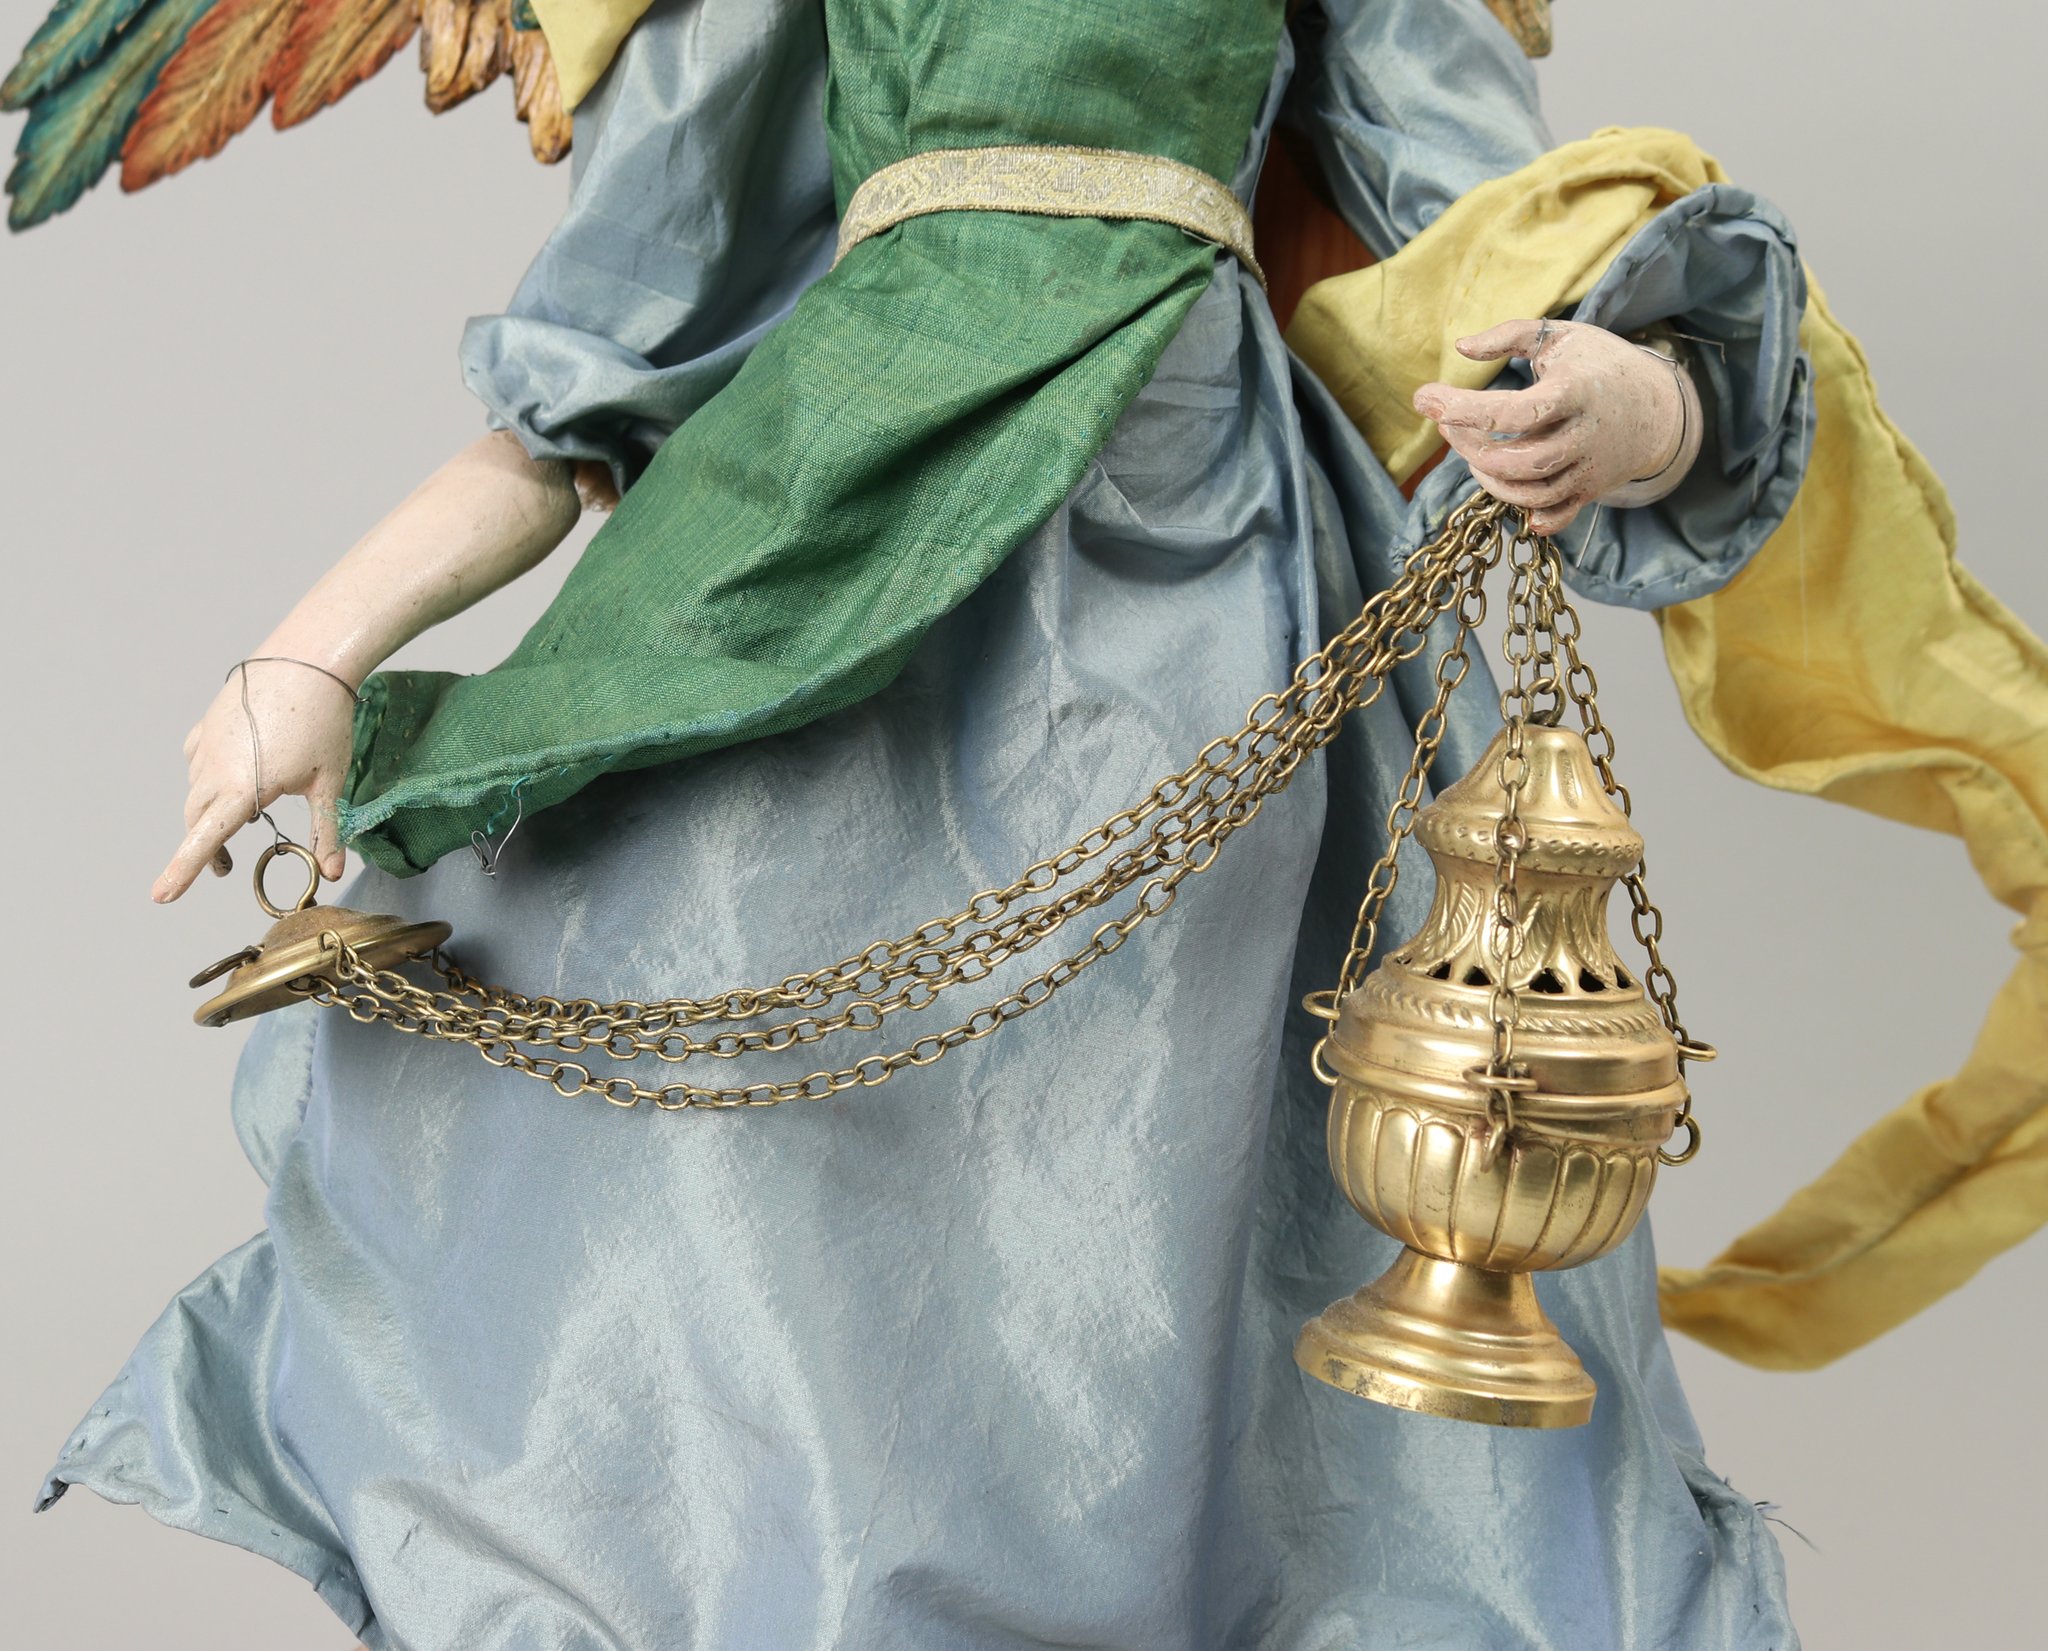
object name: crèche figure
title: Censer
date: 1751-1800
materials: silver gilt